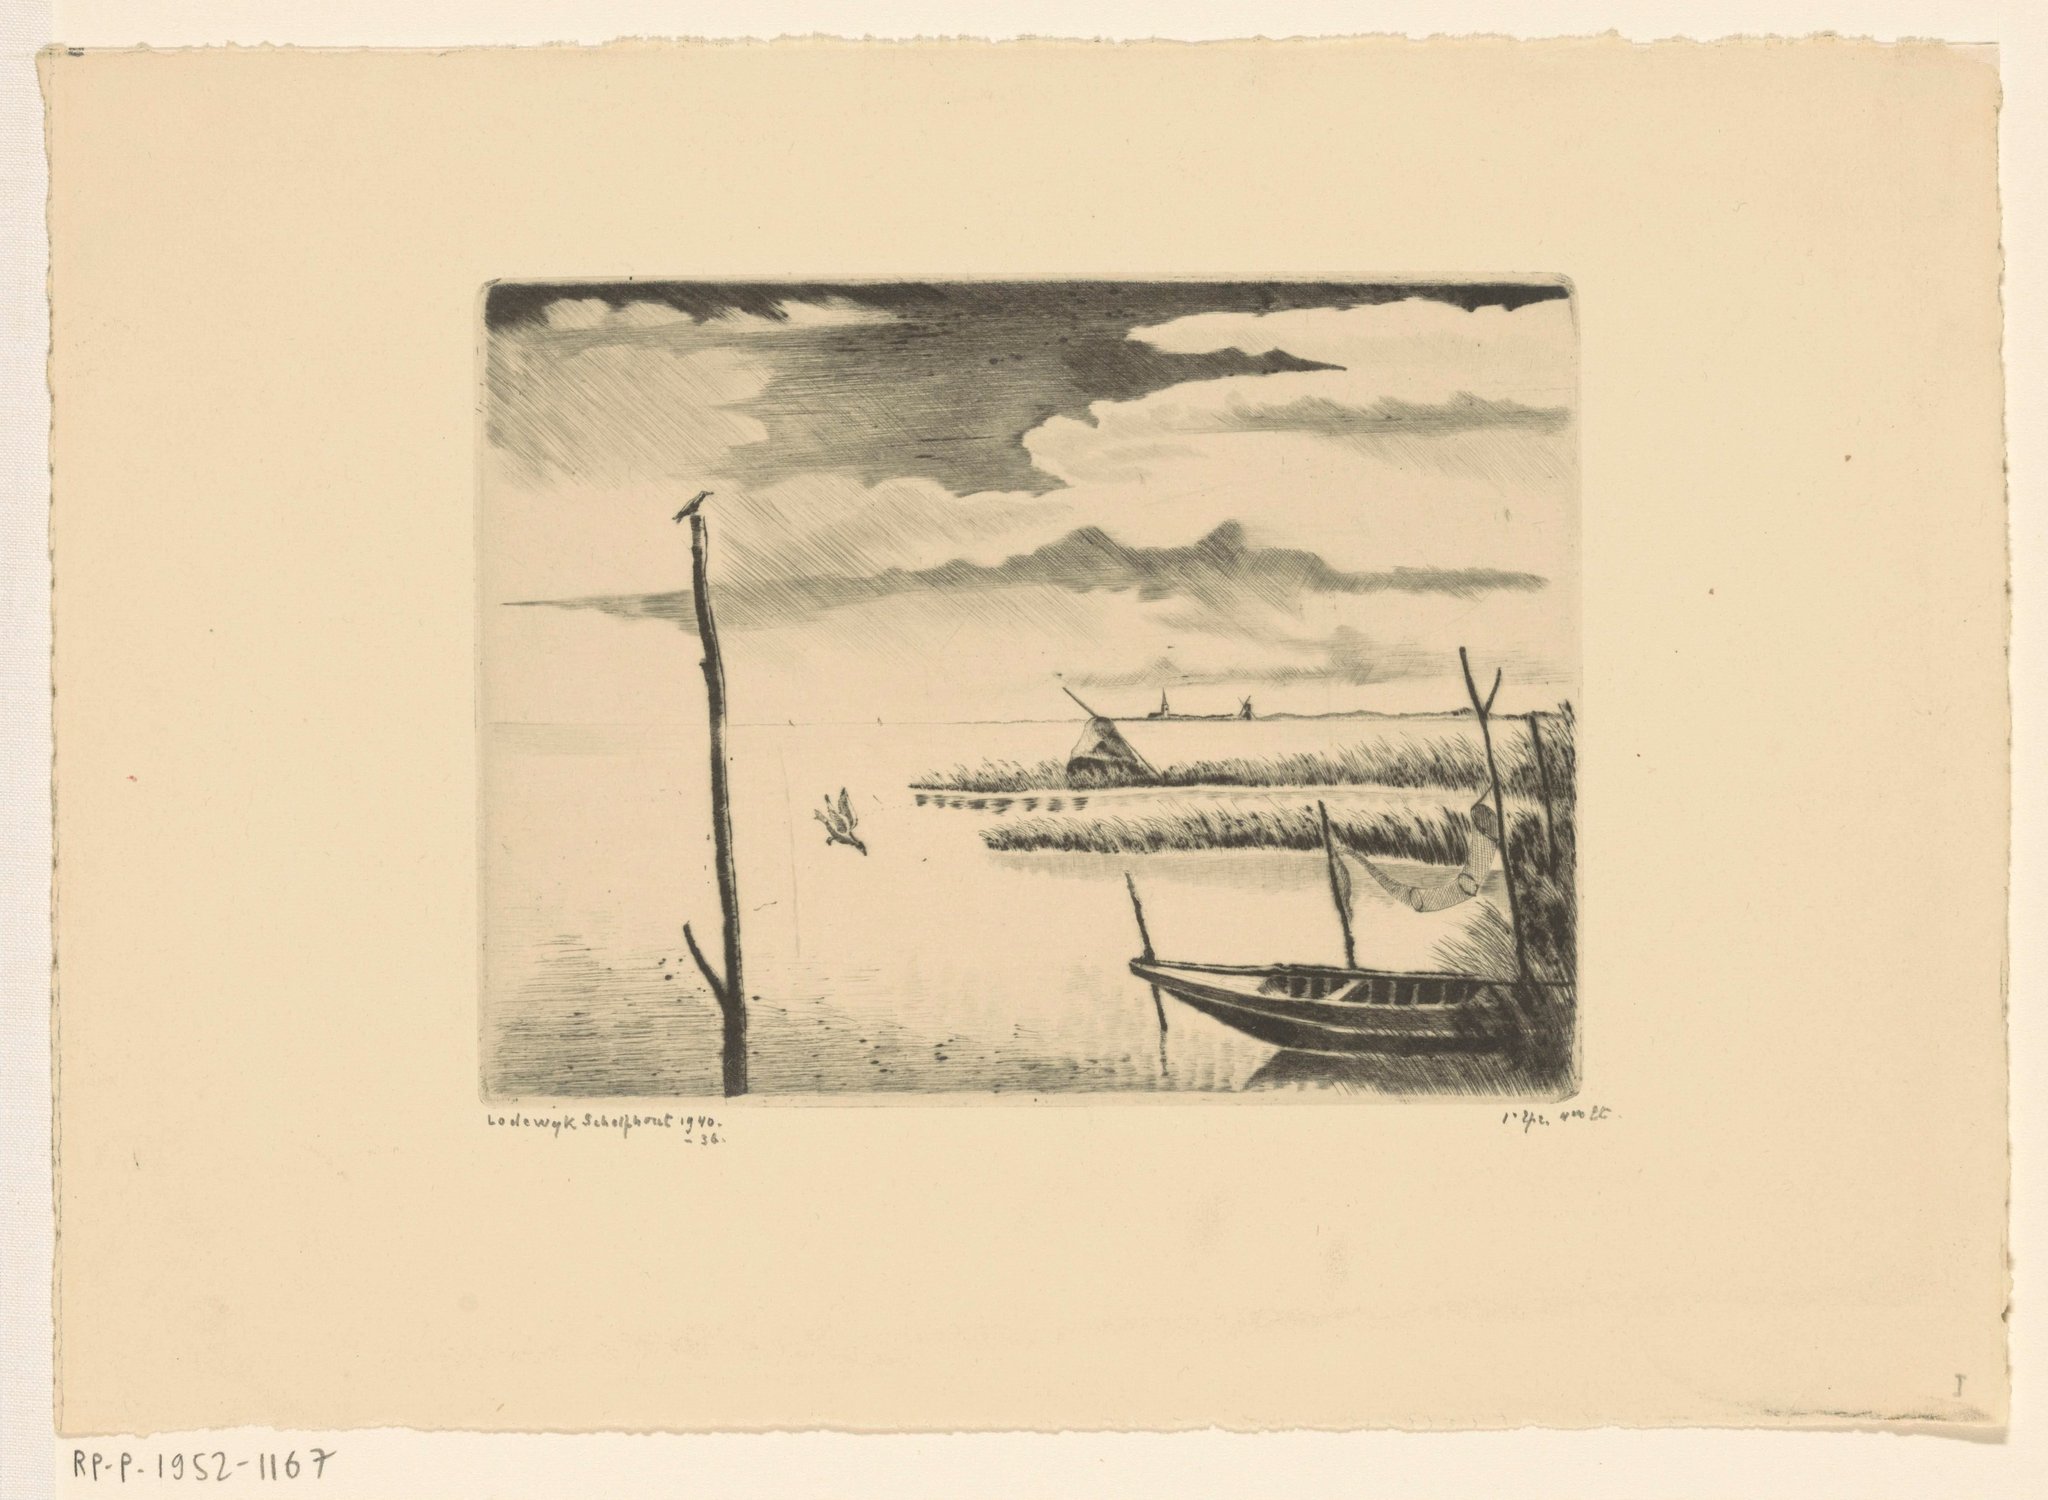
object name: print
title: Le Lac de Kortenhoef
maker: lodewijk schelfhout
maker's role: draughtsman, print maker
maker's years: 1881-1943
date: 1936-1940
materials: paper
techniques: drypoint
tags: rowing-boat, canoe, etc., lake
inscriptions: collector's mark: Lugt 2228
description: Rechts op de voorgrond een afgemeerde schuit.